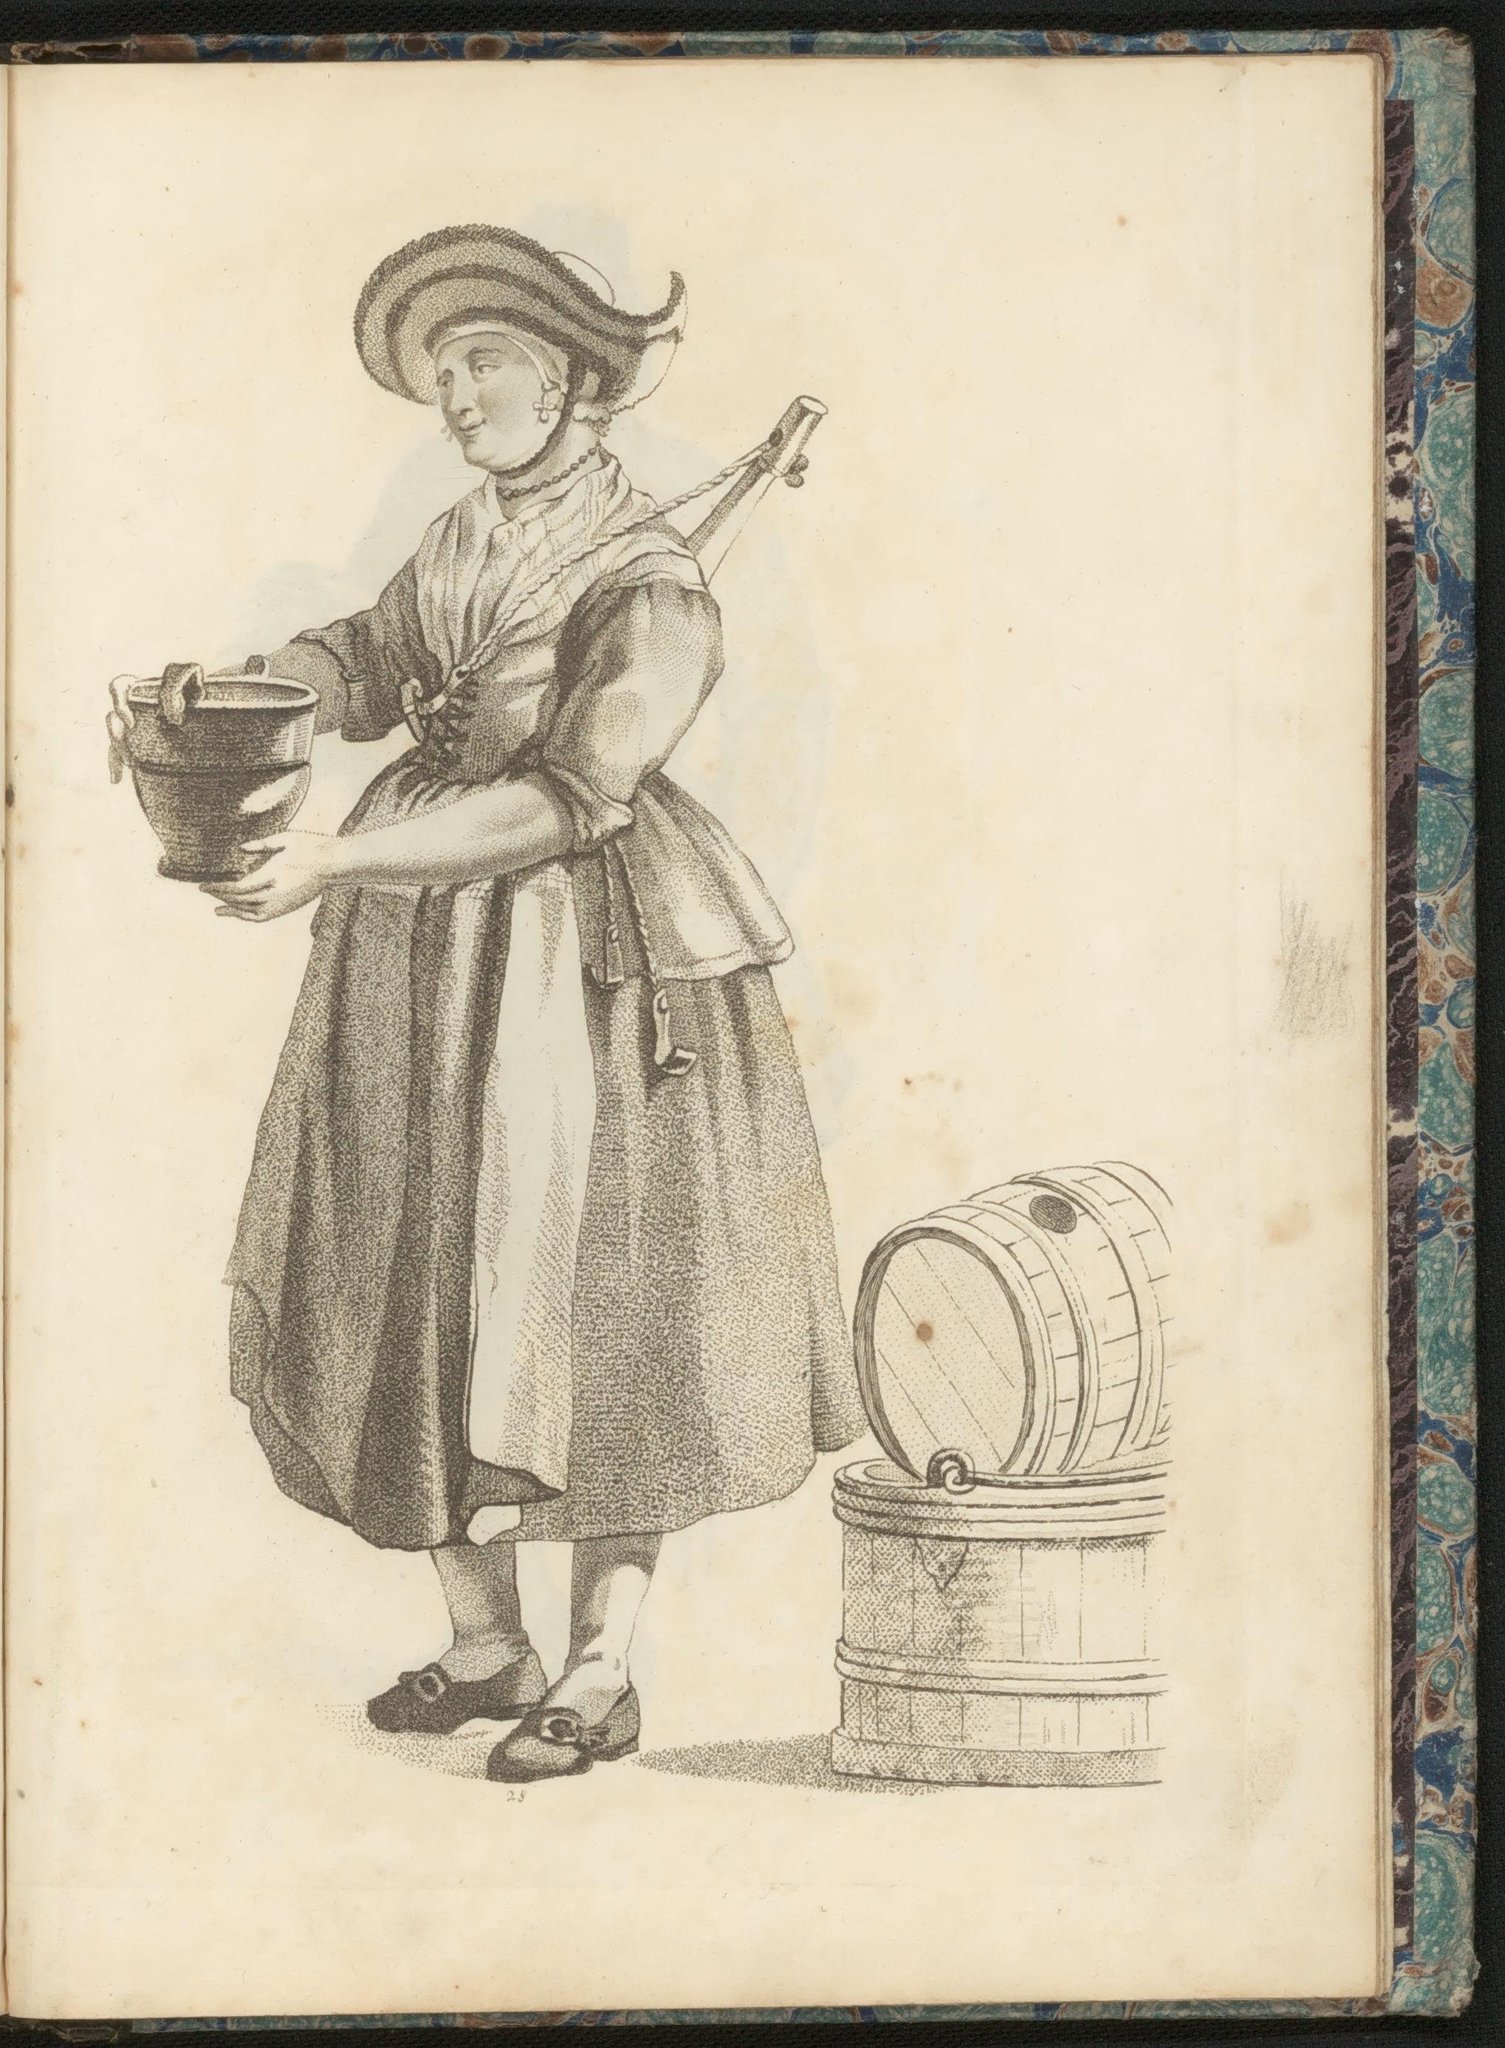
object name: print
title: Melkverkoopster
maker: mathias de sallieth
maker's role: print maker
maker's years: 1749-1791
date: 1772-1791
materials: paper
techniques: aquatint, printmaking, etching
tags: wooden container: barrel, cask, bucket, container of stone: stone vase, milkmaid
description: De prent verscheen vanaf 1818 tevens als onderdeel van een 33-delige reeks prenten door Mathias de Sallieth, samengebonden in: Perkois, Jacobus, Prins, Johannes Huibert. Verzameling van verschillende gekleede mans- en vrouwenstanden, ter oefening van jonge schilders en liefhebbers. Rotterdam: Johannes Immerzeel, 1818. Alle verso-bladen uit dit prentalbum zijn blanco.